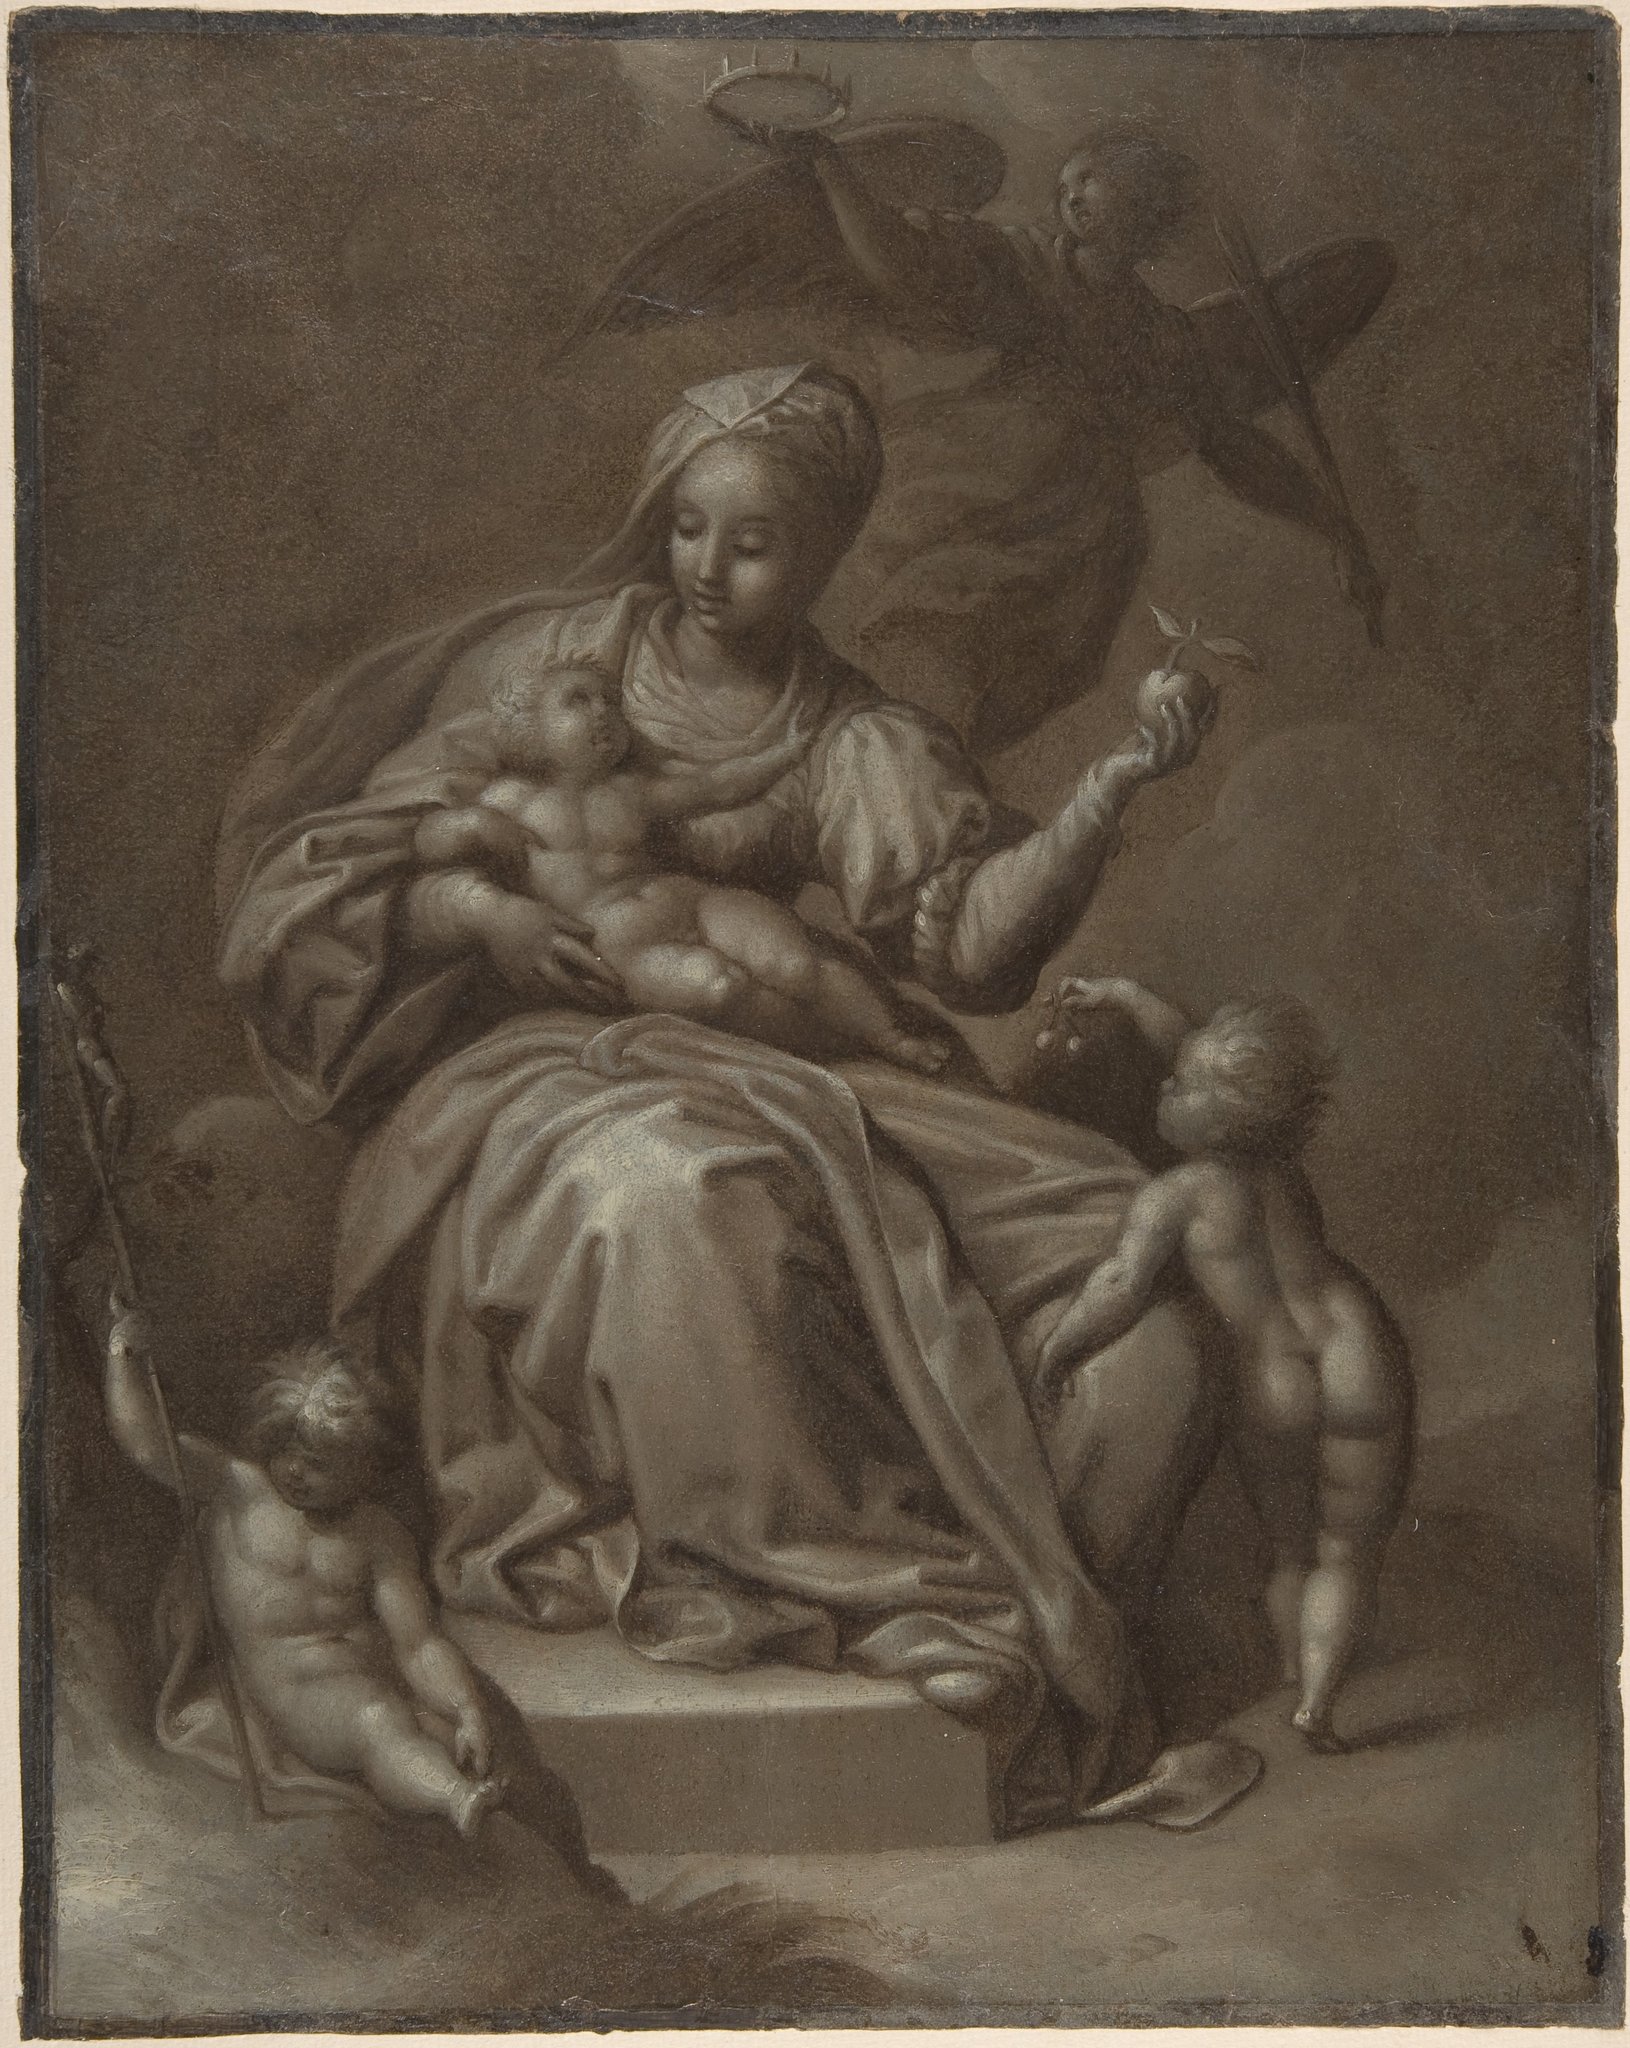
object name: drawing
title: Virgin and Child, and Saint John the Baptist (recto); Summary sketches, possibly the Virgin and Child (verso)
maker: jacob de backer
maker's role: artist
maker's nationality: netherlandish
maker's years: 1540-1600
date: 1580-1590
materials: chalk, oil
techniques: heightening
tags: angels,madonna and child,saint john the baptist